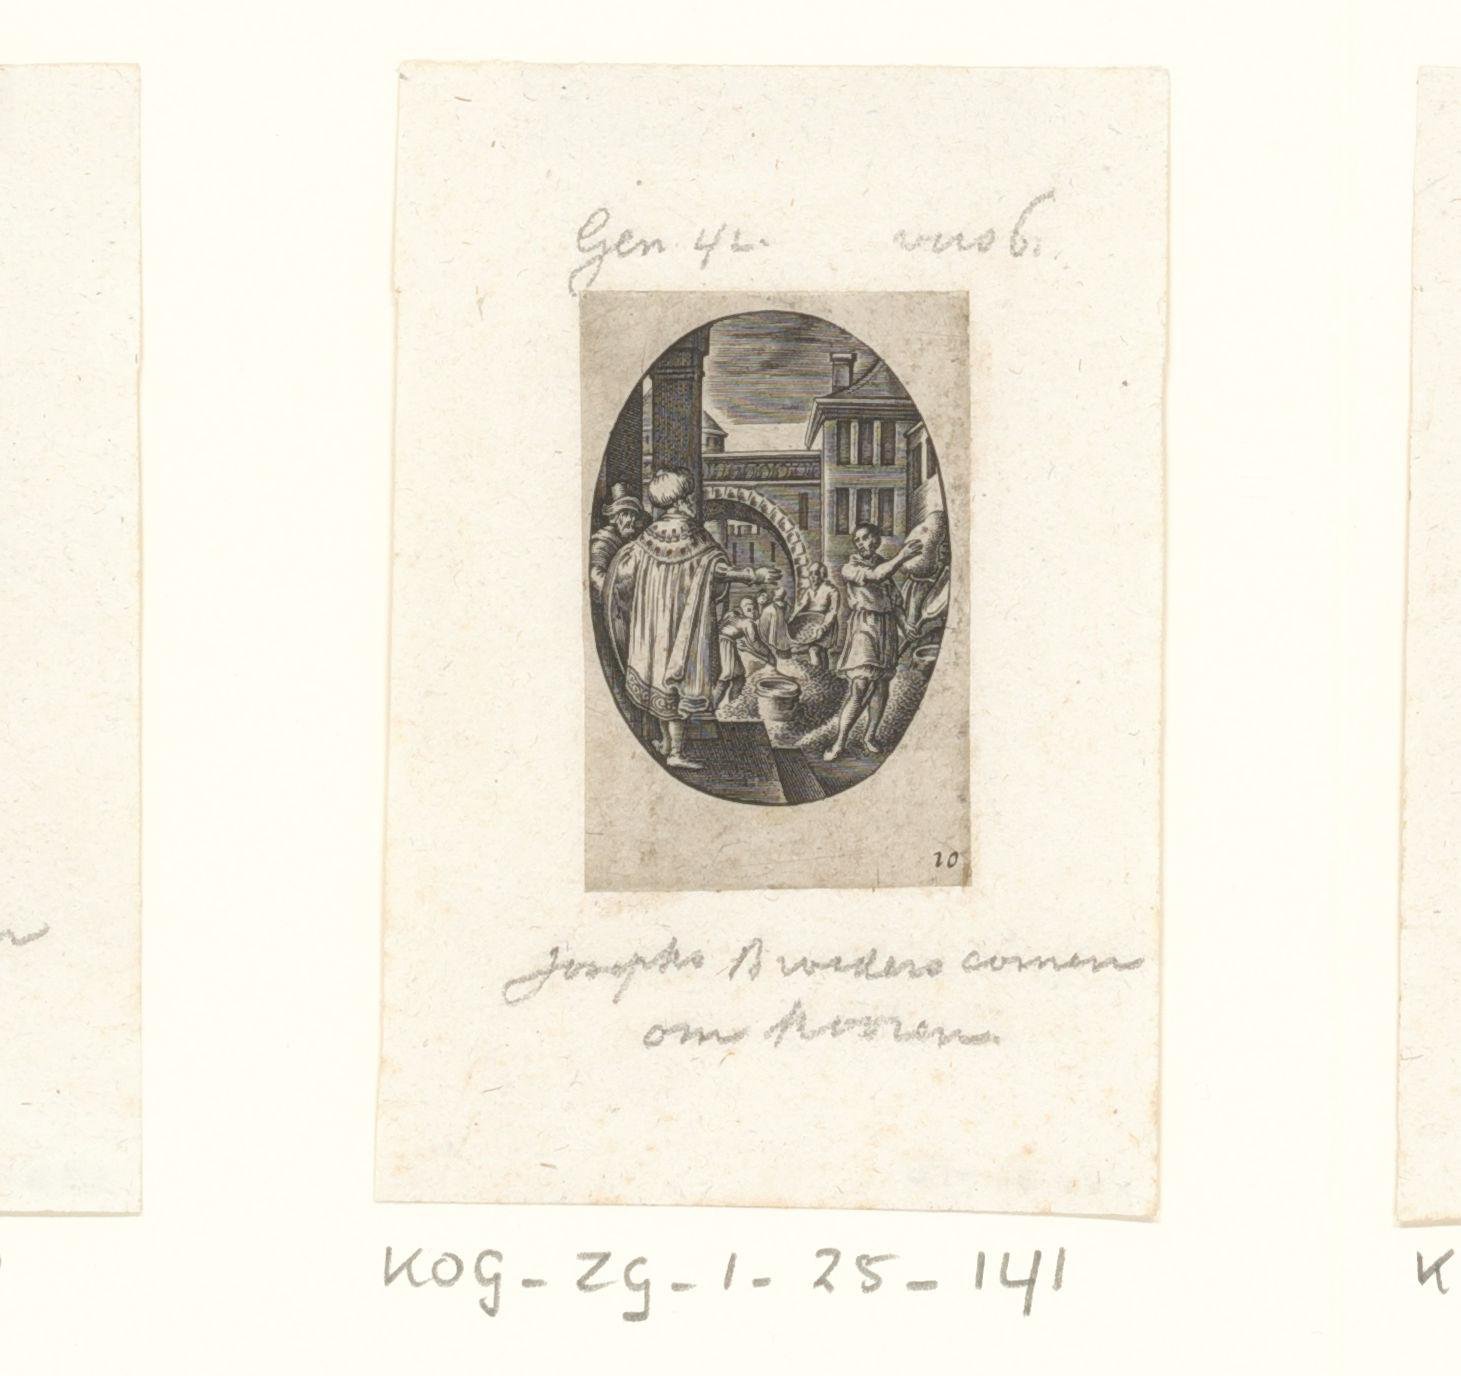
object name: print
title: Jozef verkoopt koren aan zijn broers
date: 1605-1652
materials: paper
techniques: engraving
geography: amsterdam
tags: story of joseph (part i), joseph's brothers are given corn; joseph orders money to be placed secretly in their sacks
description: De stadspoort waarbij Jozef toekijkt hoe zijn broers koren in zakken scheppen. Rechtsonder genummerd: 10. Onderwerpsrubrieken binnen de Atlas Zeden en Gewoonten: Zeden en Gewoonten in Engeren Zin, De Woning, Huisraad, Zilverwerk.